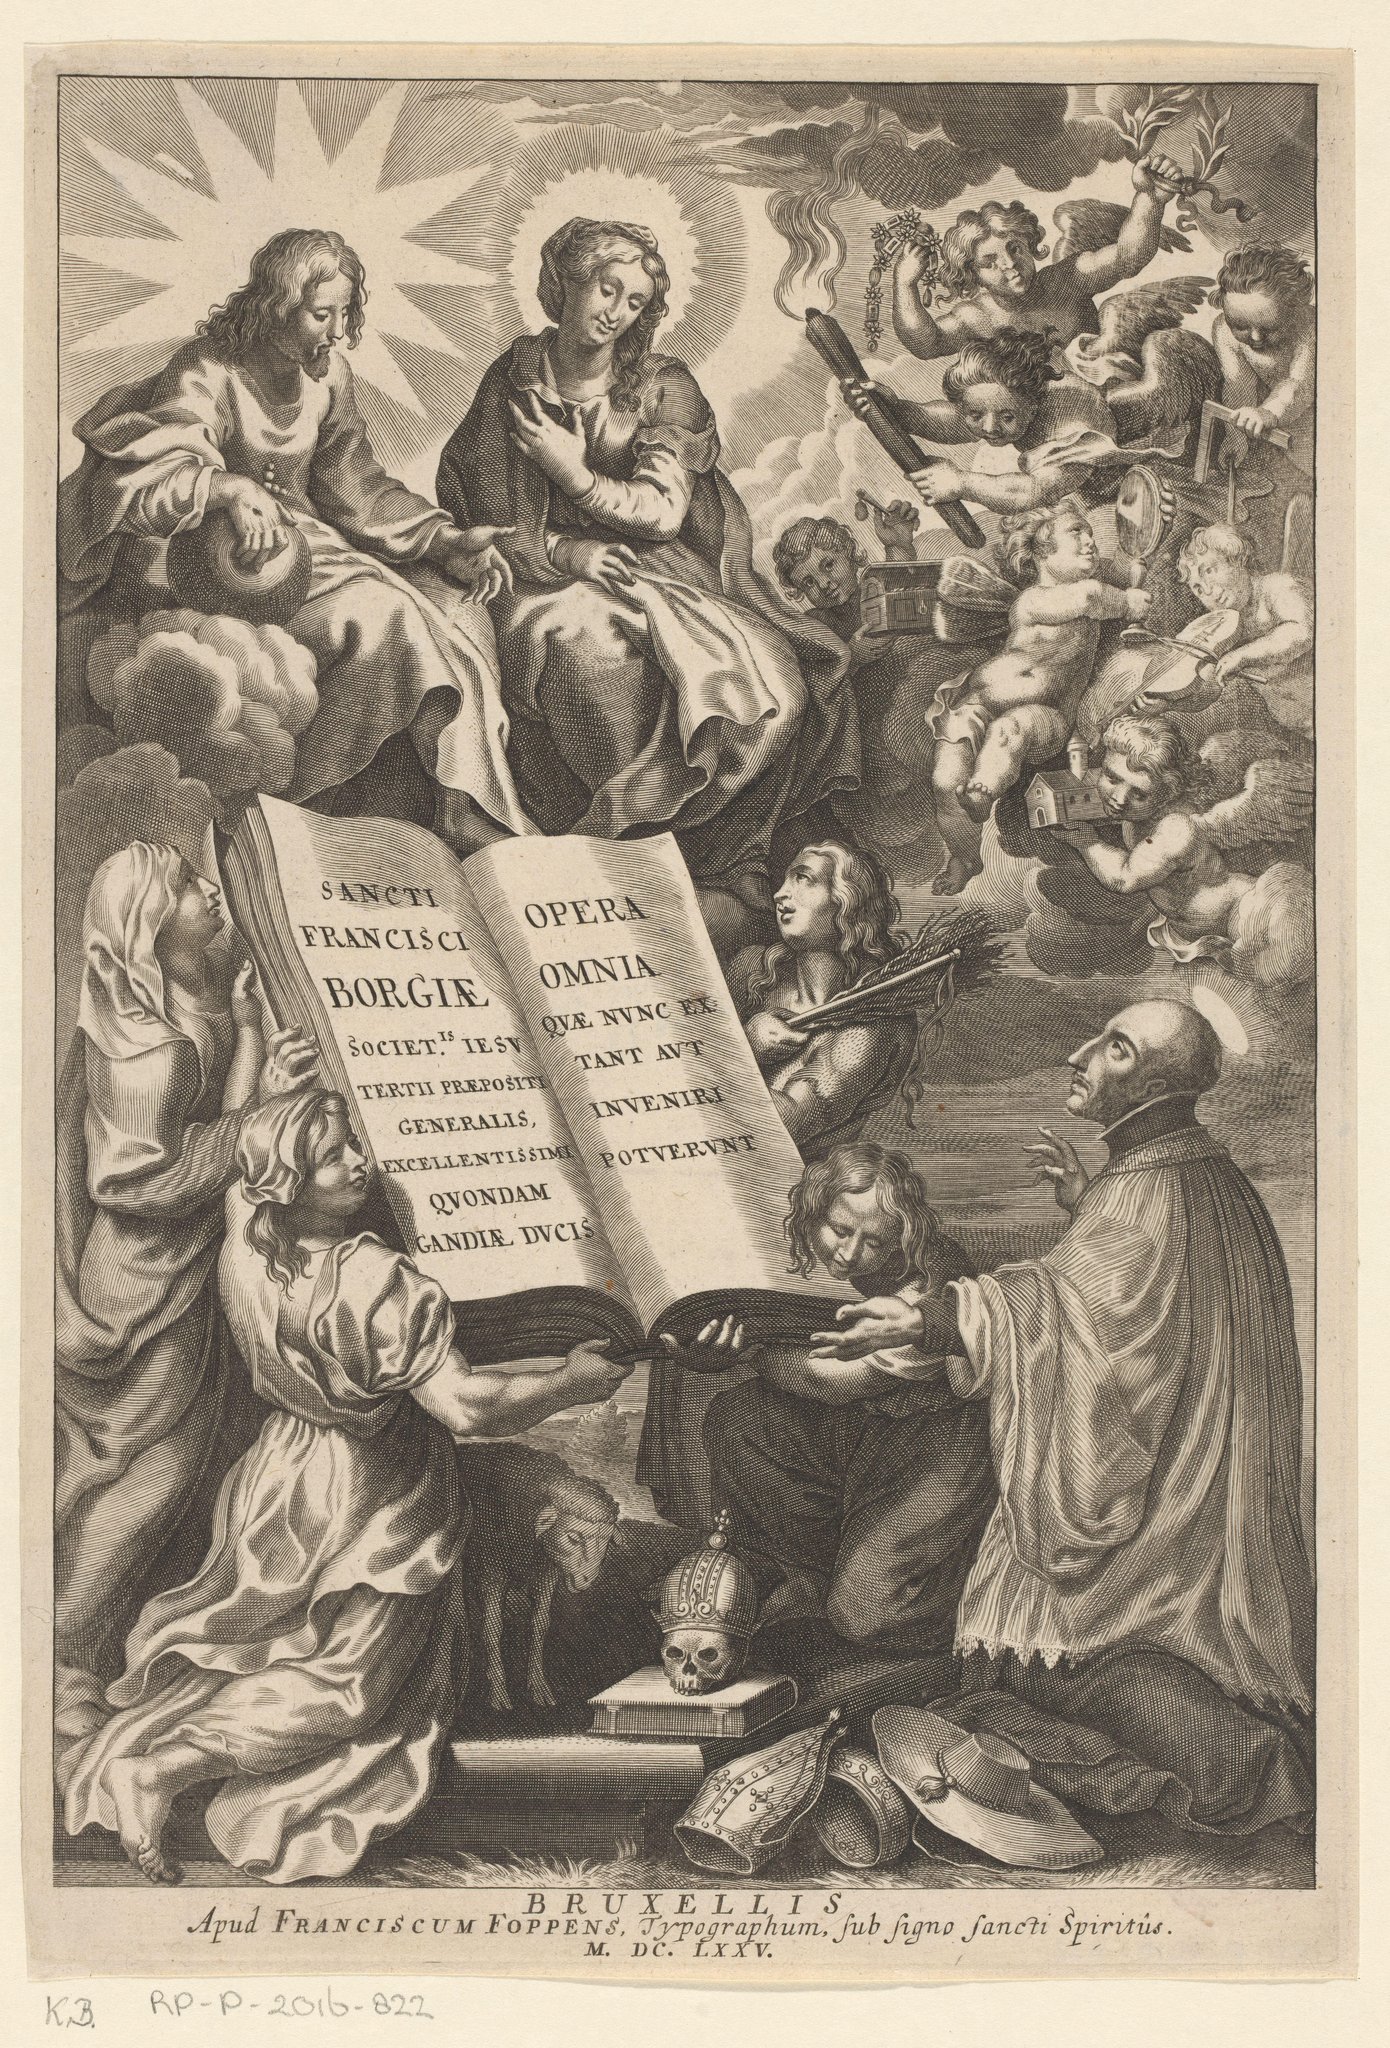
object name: print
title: Titelpagina voor: Franciscus Borgia, Opera Omnia, 1675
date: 1675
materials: paper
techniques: engraving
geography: brussels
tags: clergyman, the virgin mary, christ, book, writer, poet, author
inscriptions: collector's mark: Lugt 240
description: Franciscus Borgia knielt en biedt zijn boek aan Christus en Maria aan. Het boek wordt gedragen door de personificaties van de monastieke deugden (mystieke theologie, een goed karakter, nederigheid en matige zelfkastijding). Rechts boven een groep engelen met attributen die verband houden met de inhoud van het boek.